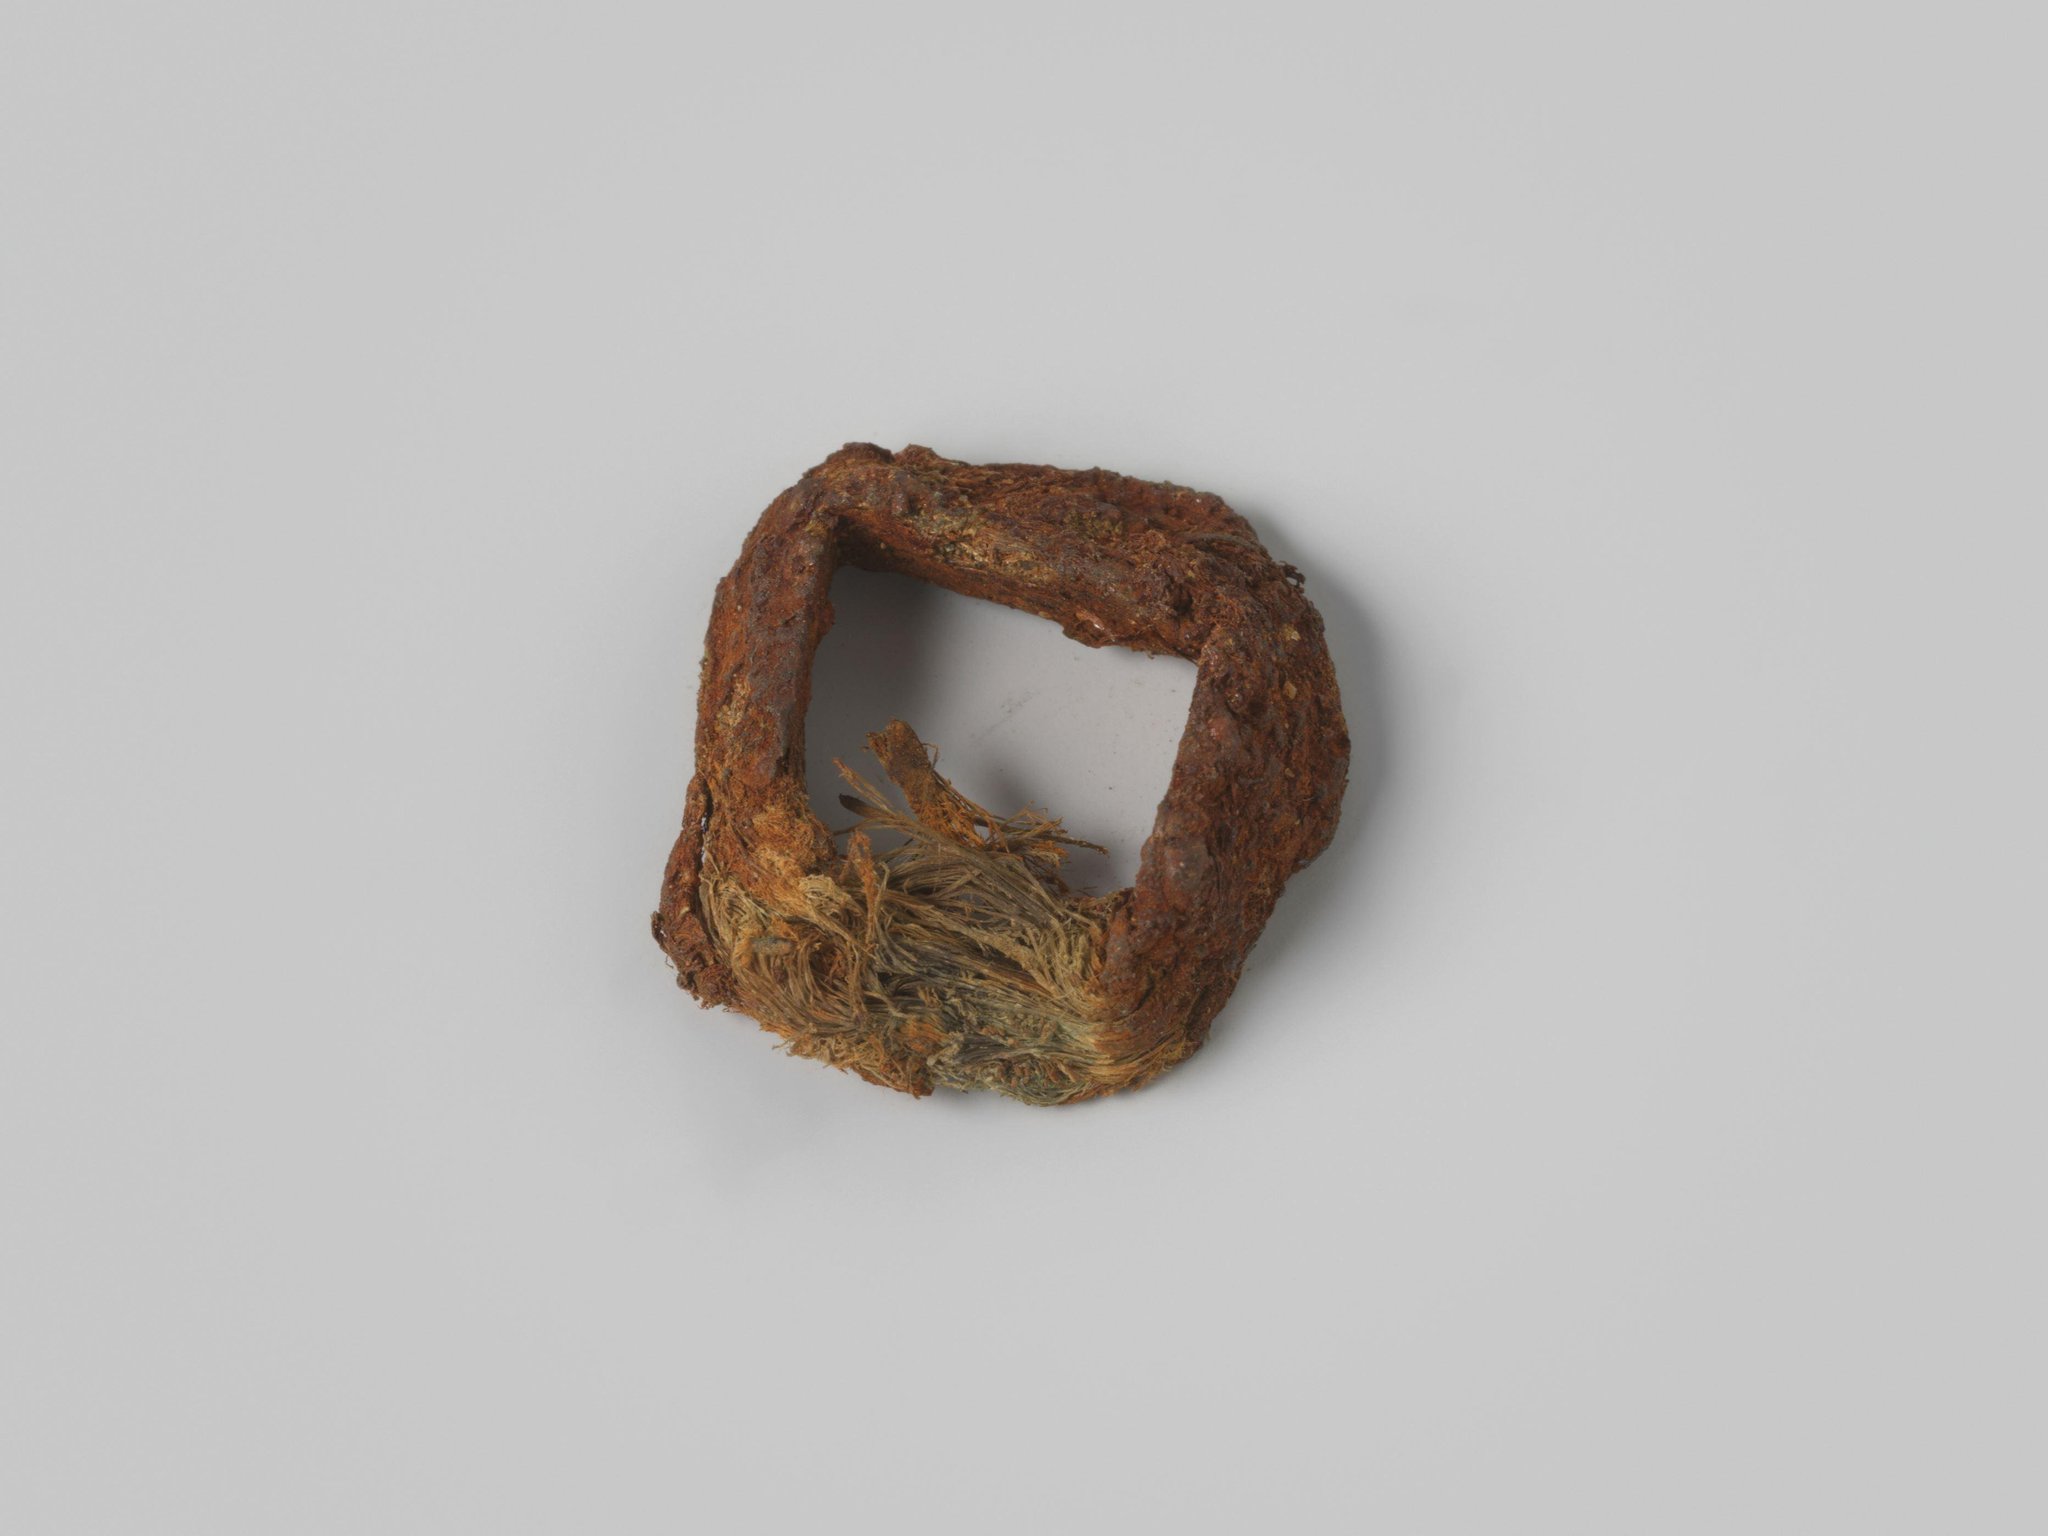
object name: sluitring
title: Sluitring van een gevest uit het wrak van de Oost-Indiëvaarder Hollandia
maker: Anonymous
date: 1700-1743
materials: fiber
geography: netherlands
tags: verenigde oostindische compagnie, hollandia (schip), annet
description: Hilt, washer sim. NG 1980-27H2686, flat.